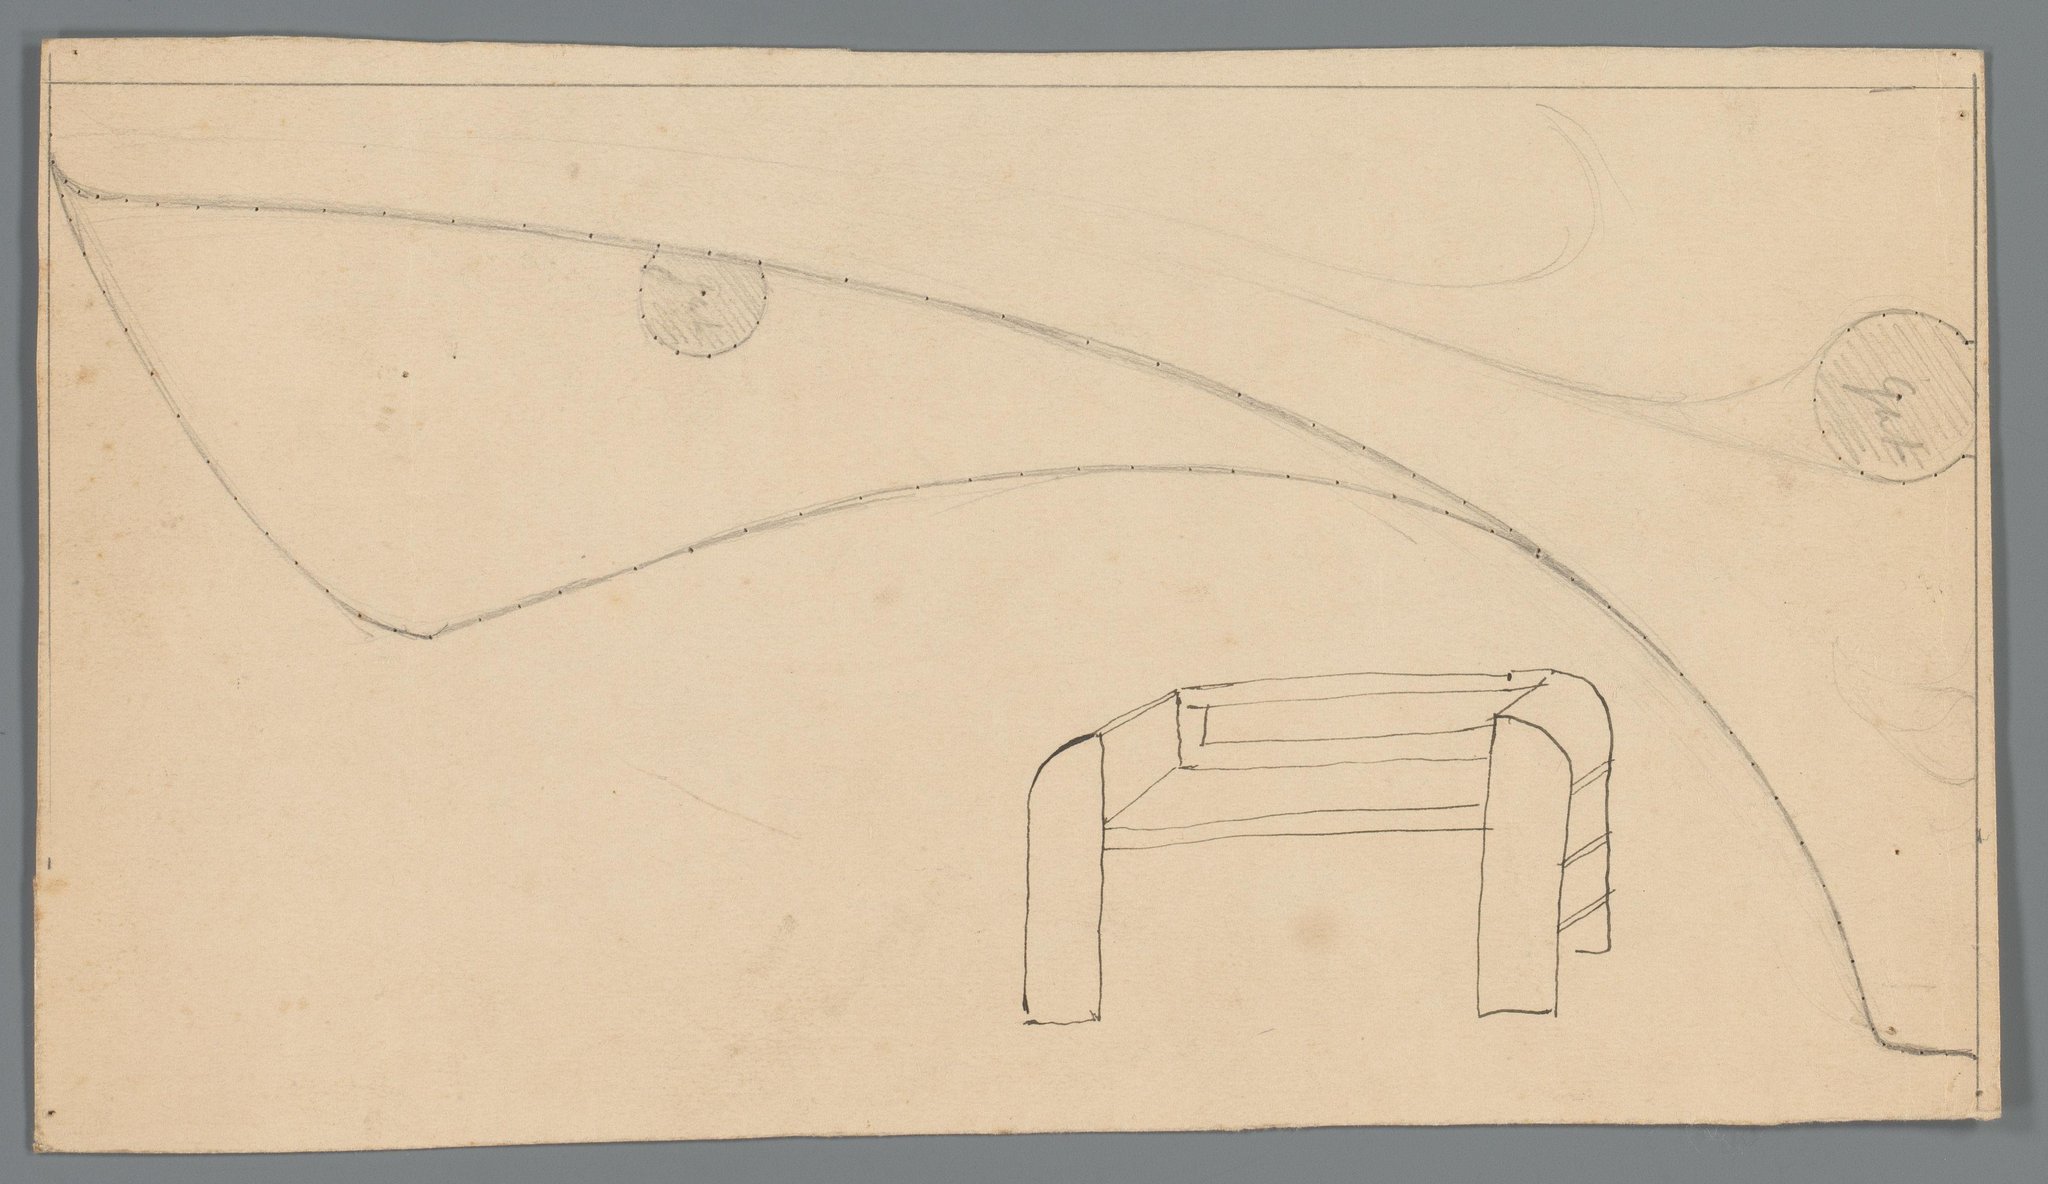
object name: design drawing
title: Ontwerp voor een stoel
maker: gust van de wall perné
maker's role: draughtsman, painter, print maker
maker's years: 1877-1911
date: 1887-1911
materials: ink, paper, pencil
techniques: pen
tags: chair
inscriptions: collector's mark: Lugt 2228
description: Met mogelijk een sjabloon voor een armleuning. Met op verso een fragment van een schets.